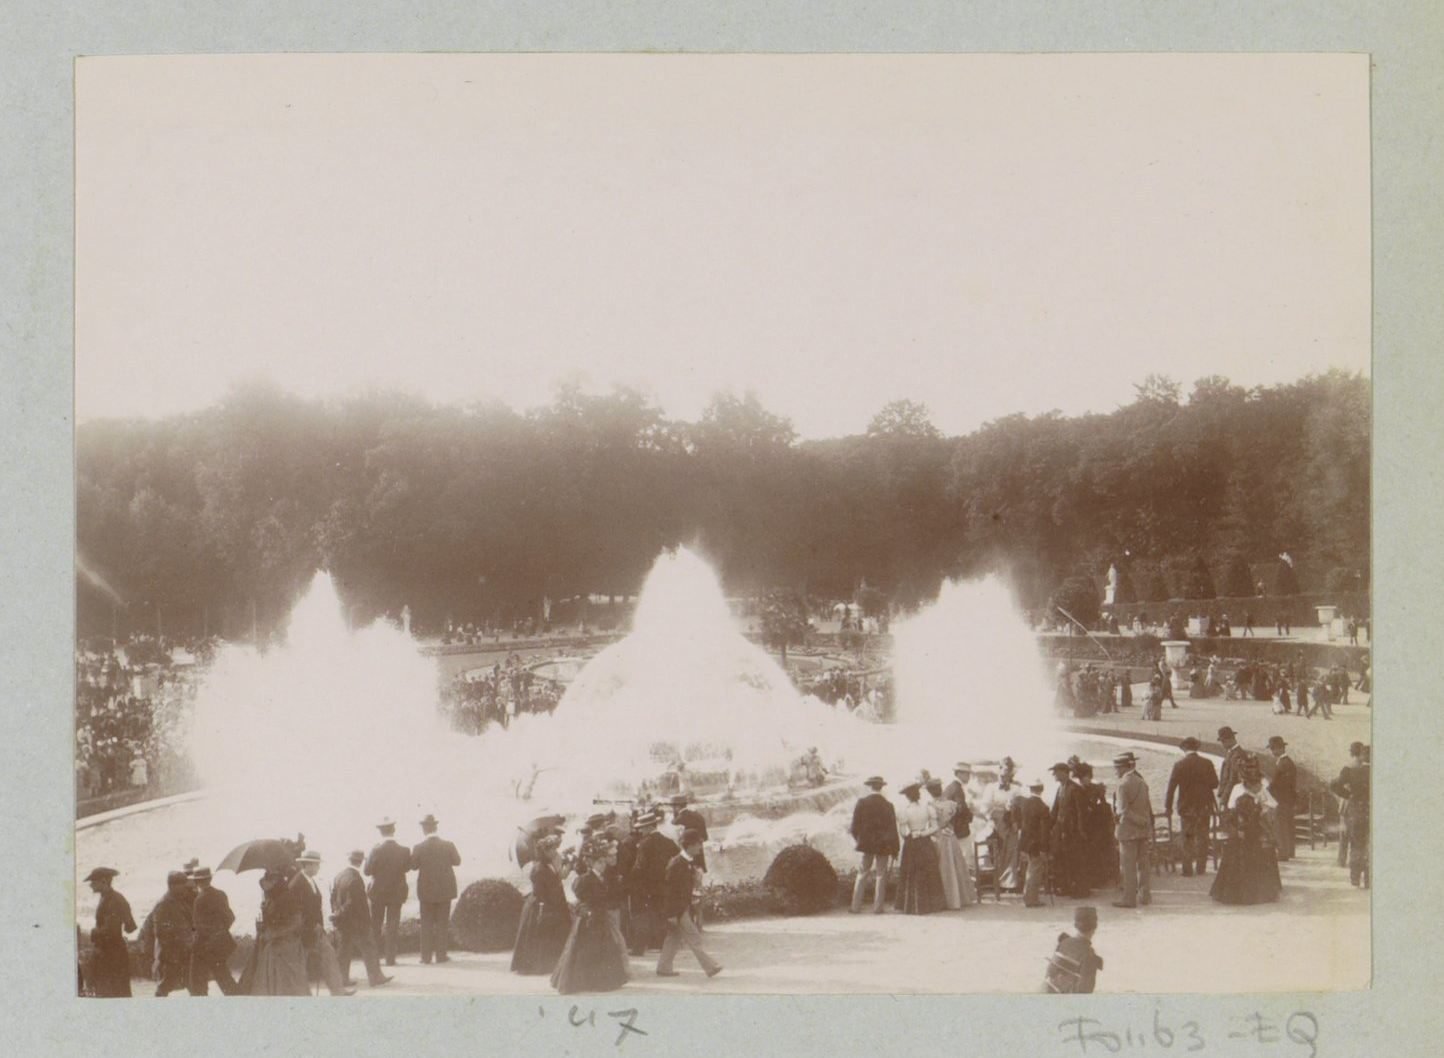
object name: photograph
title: Publiek bij fonteinen in Versailles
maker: delizy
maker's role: manufacturer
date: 1897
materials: paper, photographic support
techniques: gelatin silver print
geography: versailles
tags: garden fountain, public gardens, park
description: Onderdeel van Fotoalbum van een Franse amateurfotograaf met opnames van uitstapjes in Frankrijk, Spanje, België, Luxemburg en Nederland, de eerste automobielen en autoraces.